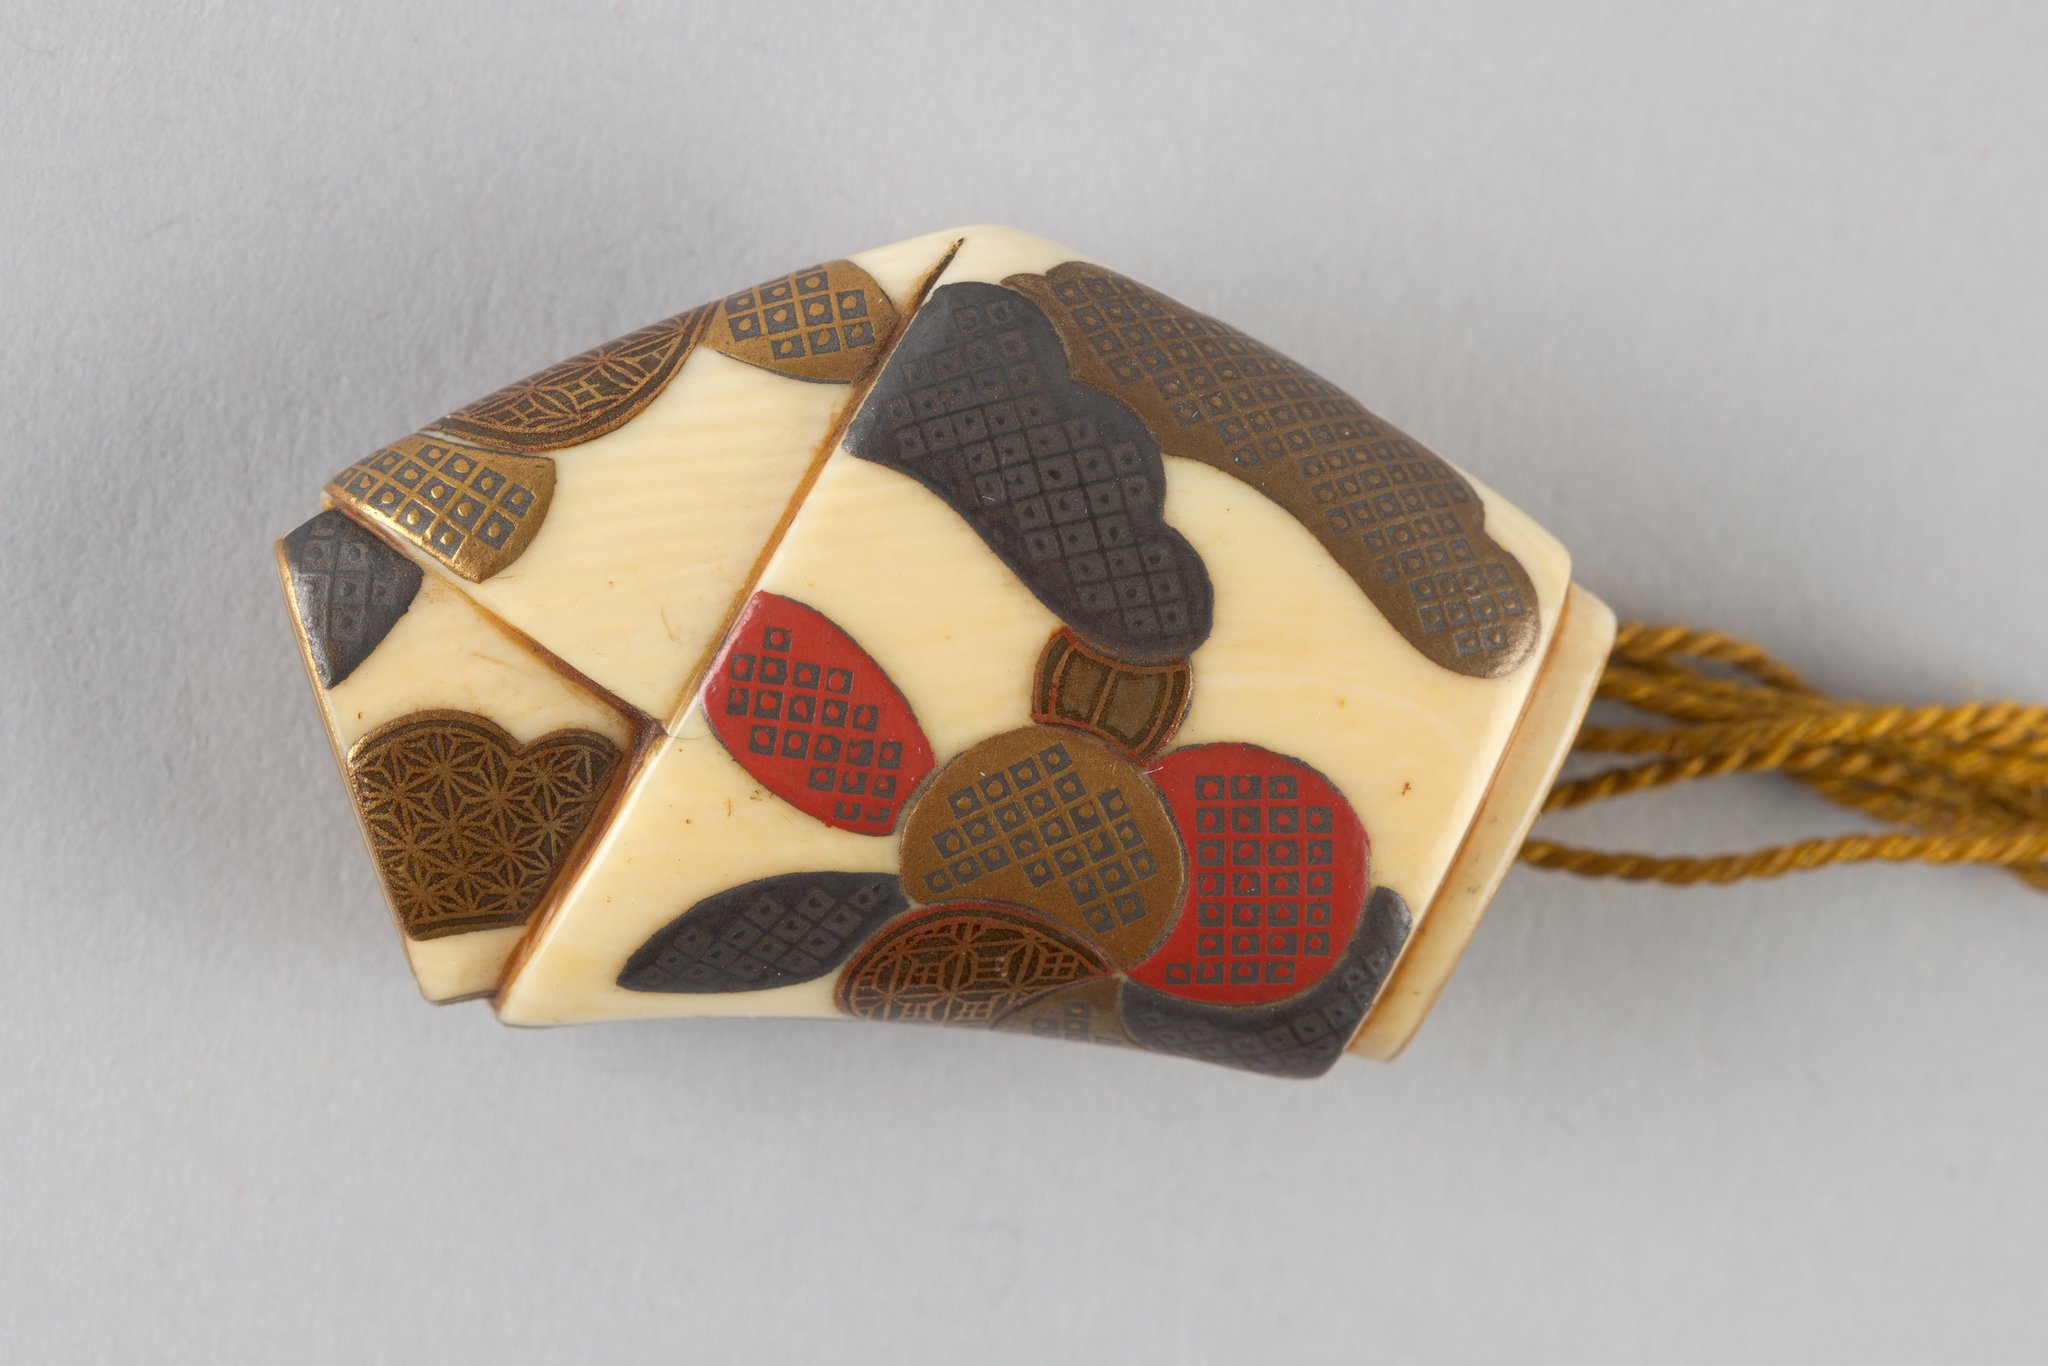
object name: netsuke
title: Netusuke in the Shape of a Knotted Letter, with Problems Written on and Tied to Branches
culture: japanese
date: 1801-1900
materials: ivory, lacquer